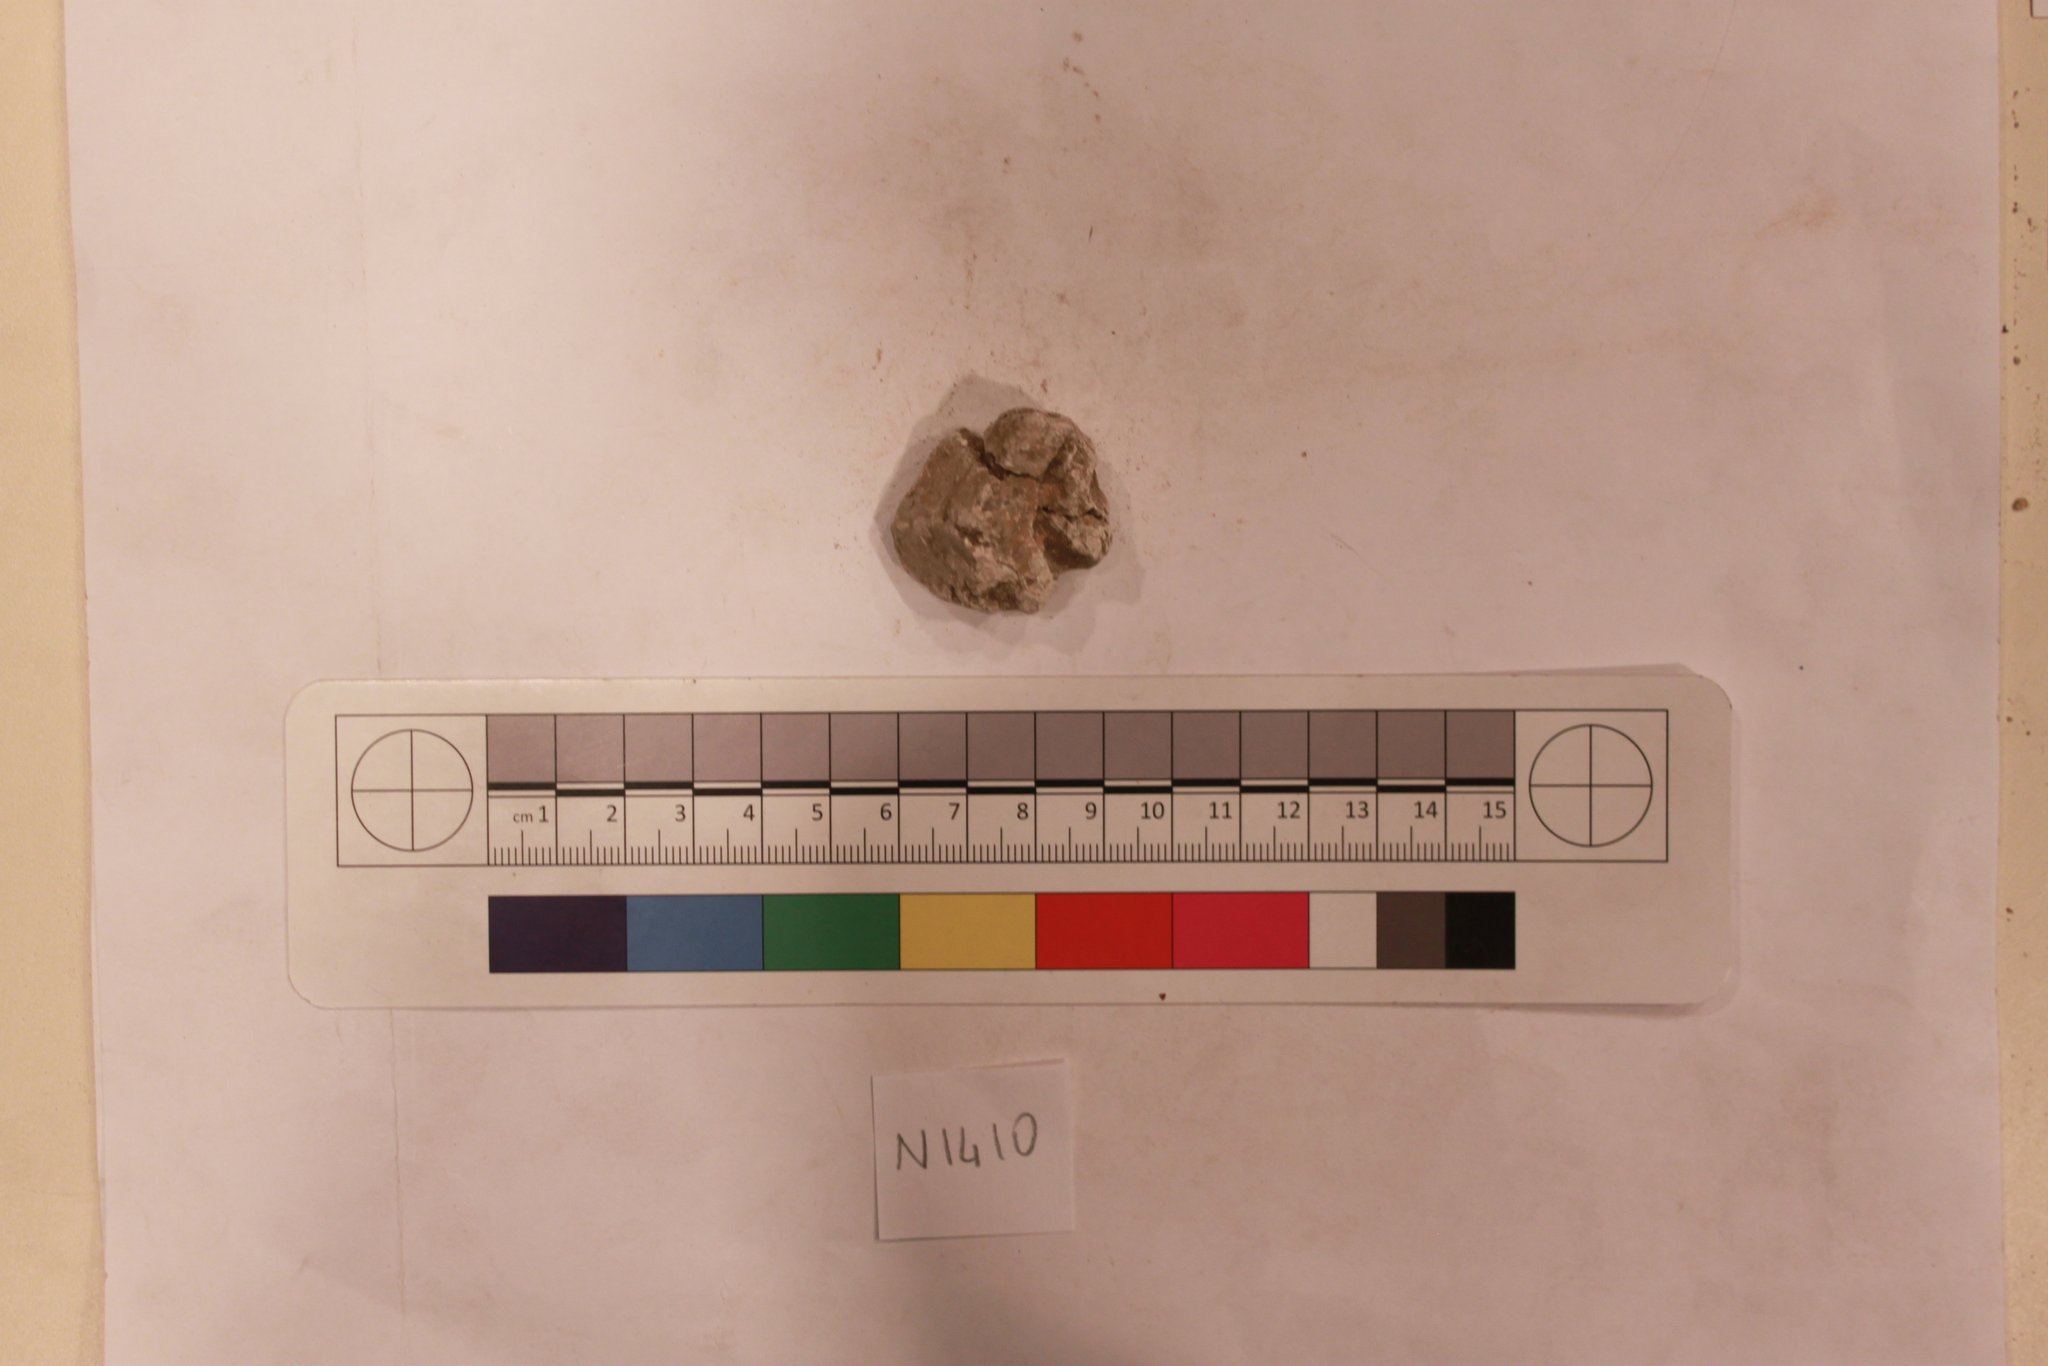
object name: fragment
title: Stucco Fragment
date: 701-1200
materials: plaster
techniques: carving, painting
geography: iran